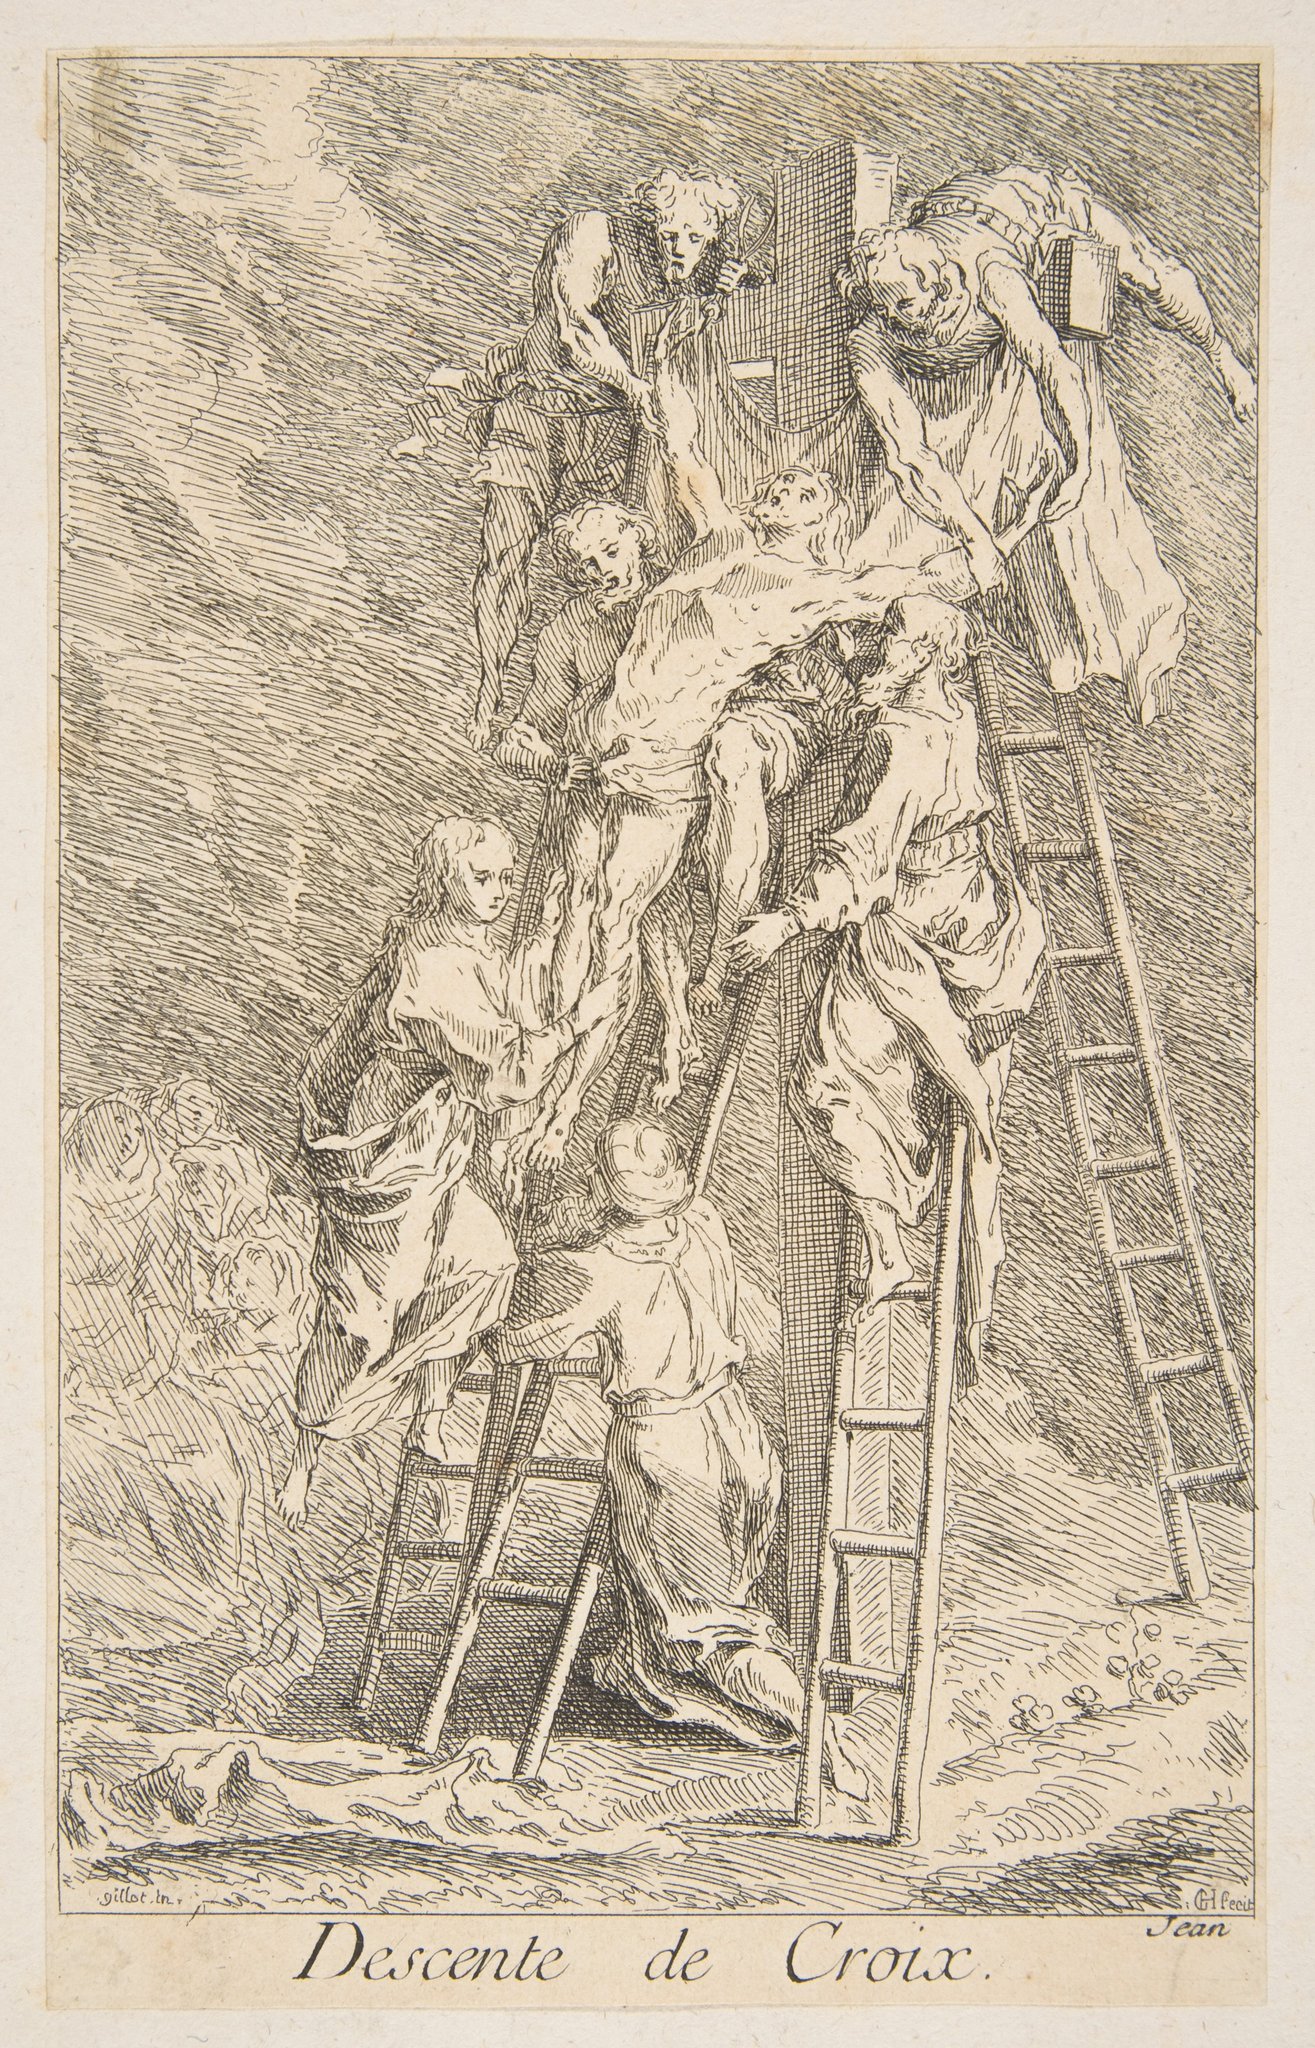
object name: print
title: Descent from the Cross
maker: claude gillot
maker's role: artist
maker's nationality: french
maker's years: 1673-1722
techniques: etching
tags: men,christ,cross,descent from the cross,ladders